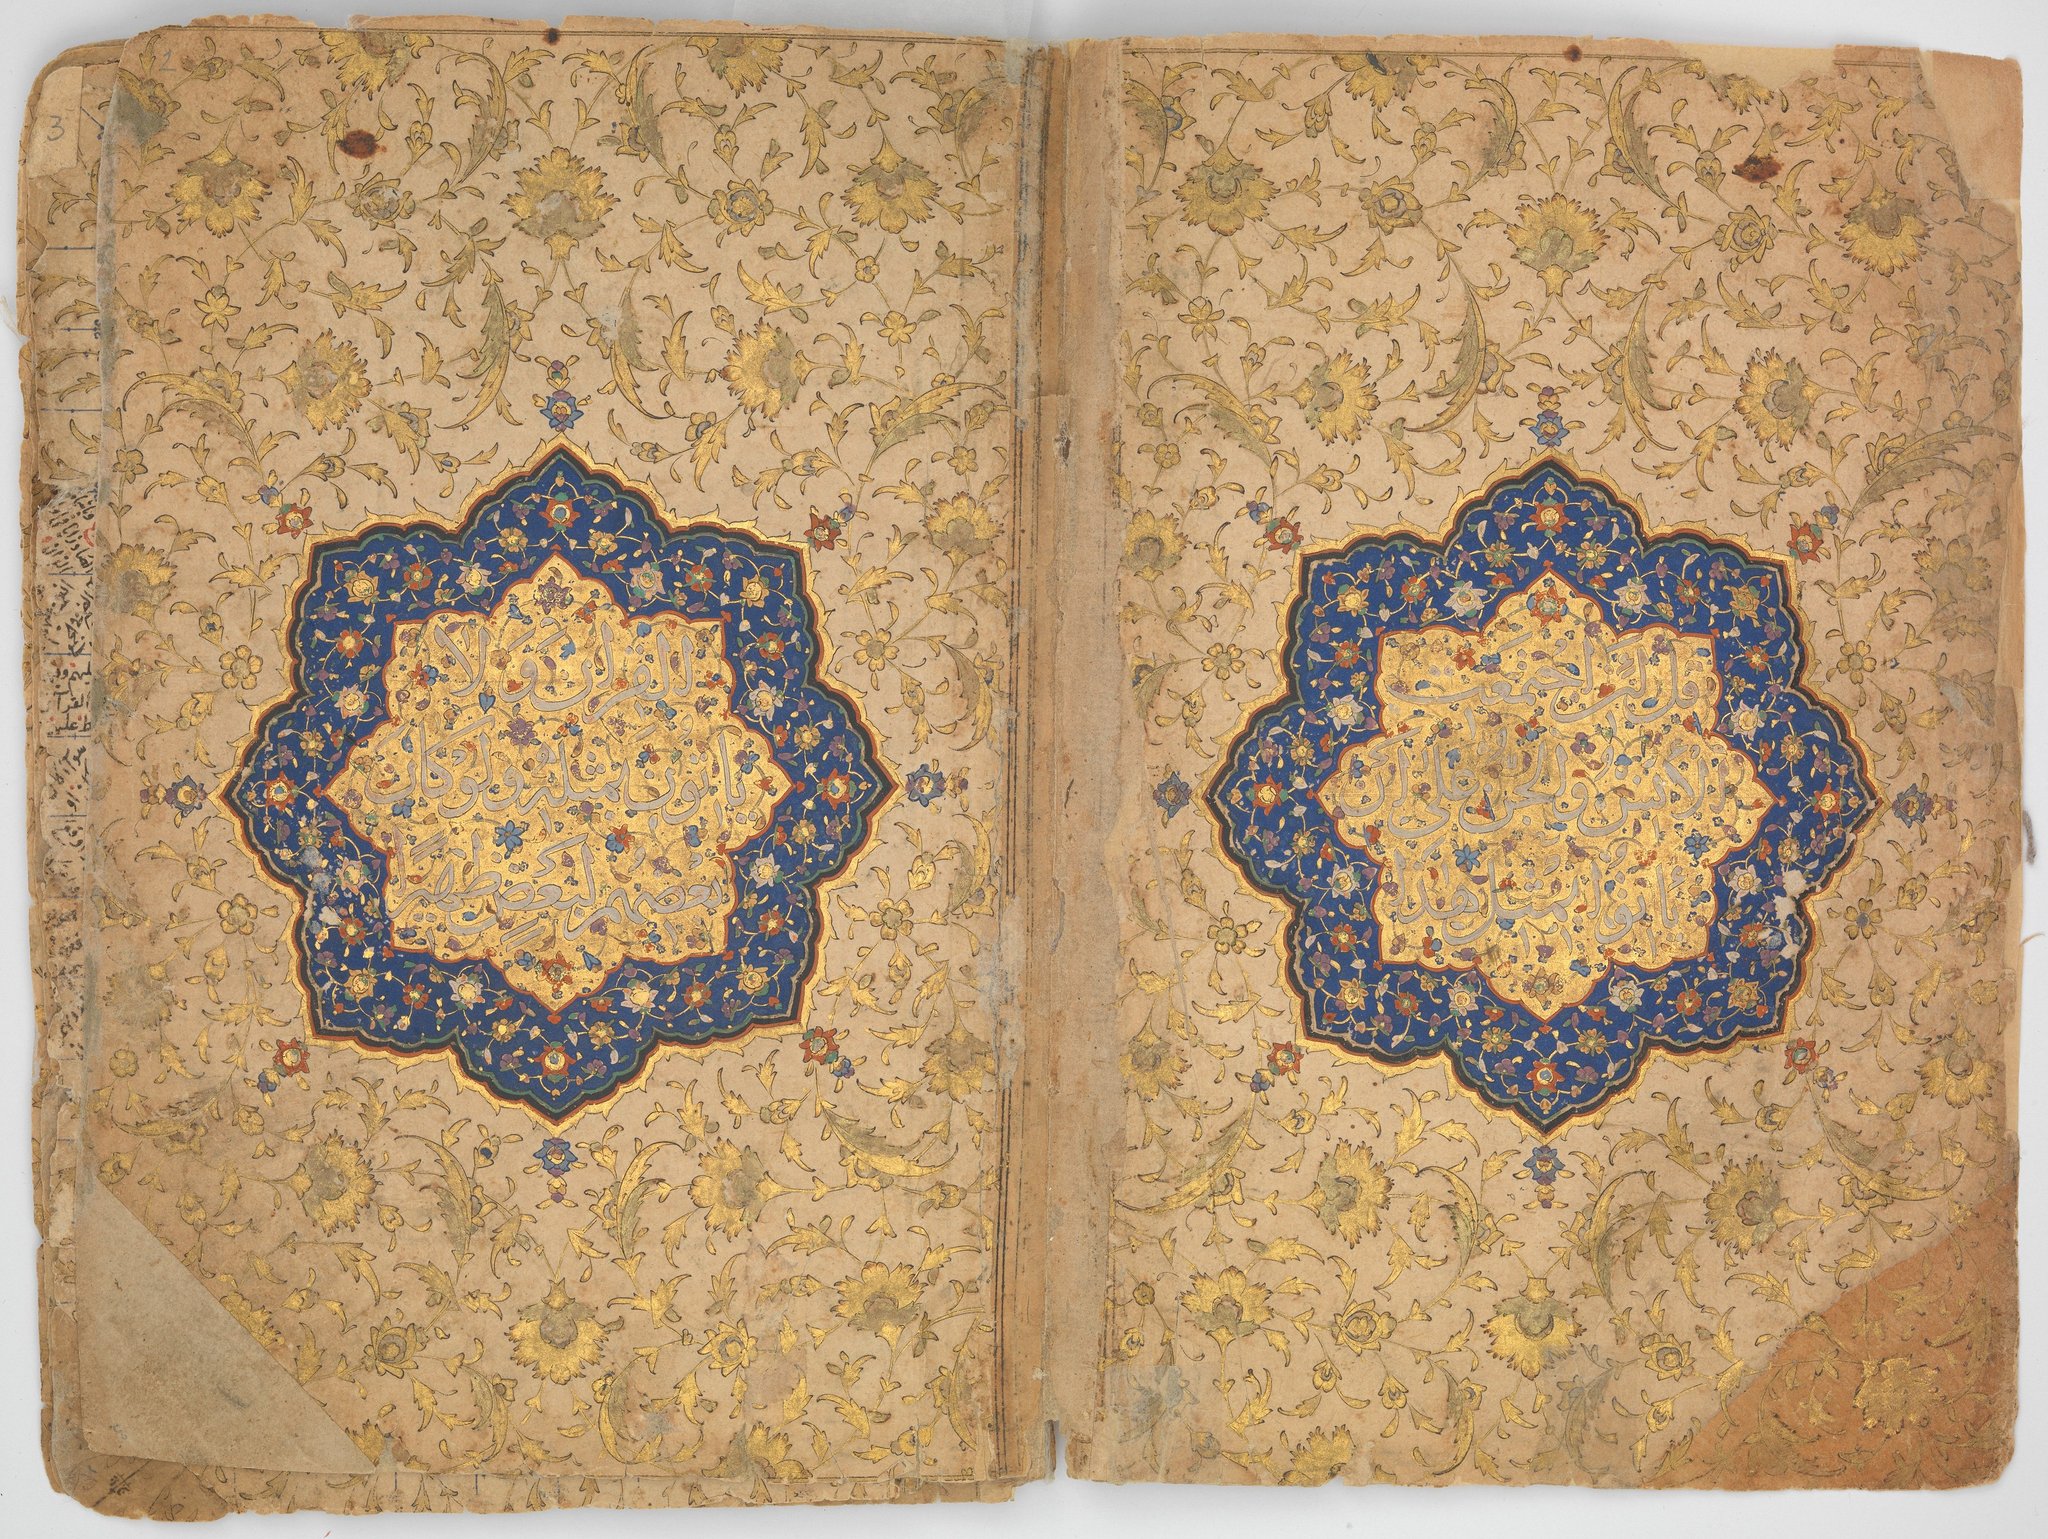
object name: non illustrated manuscript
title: Qur'an of Ibrahim Sultan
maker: ibrahim sultan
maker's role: calligrapher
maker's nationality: iranian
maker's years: 1370-1435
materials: gold, ink, paper, watercolor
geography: iran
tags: flowers